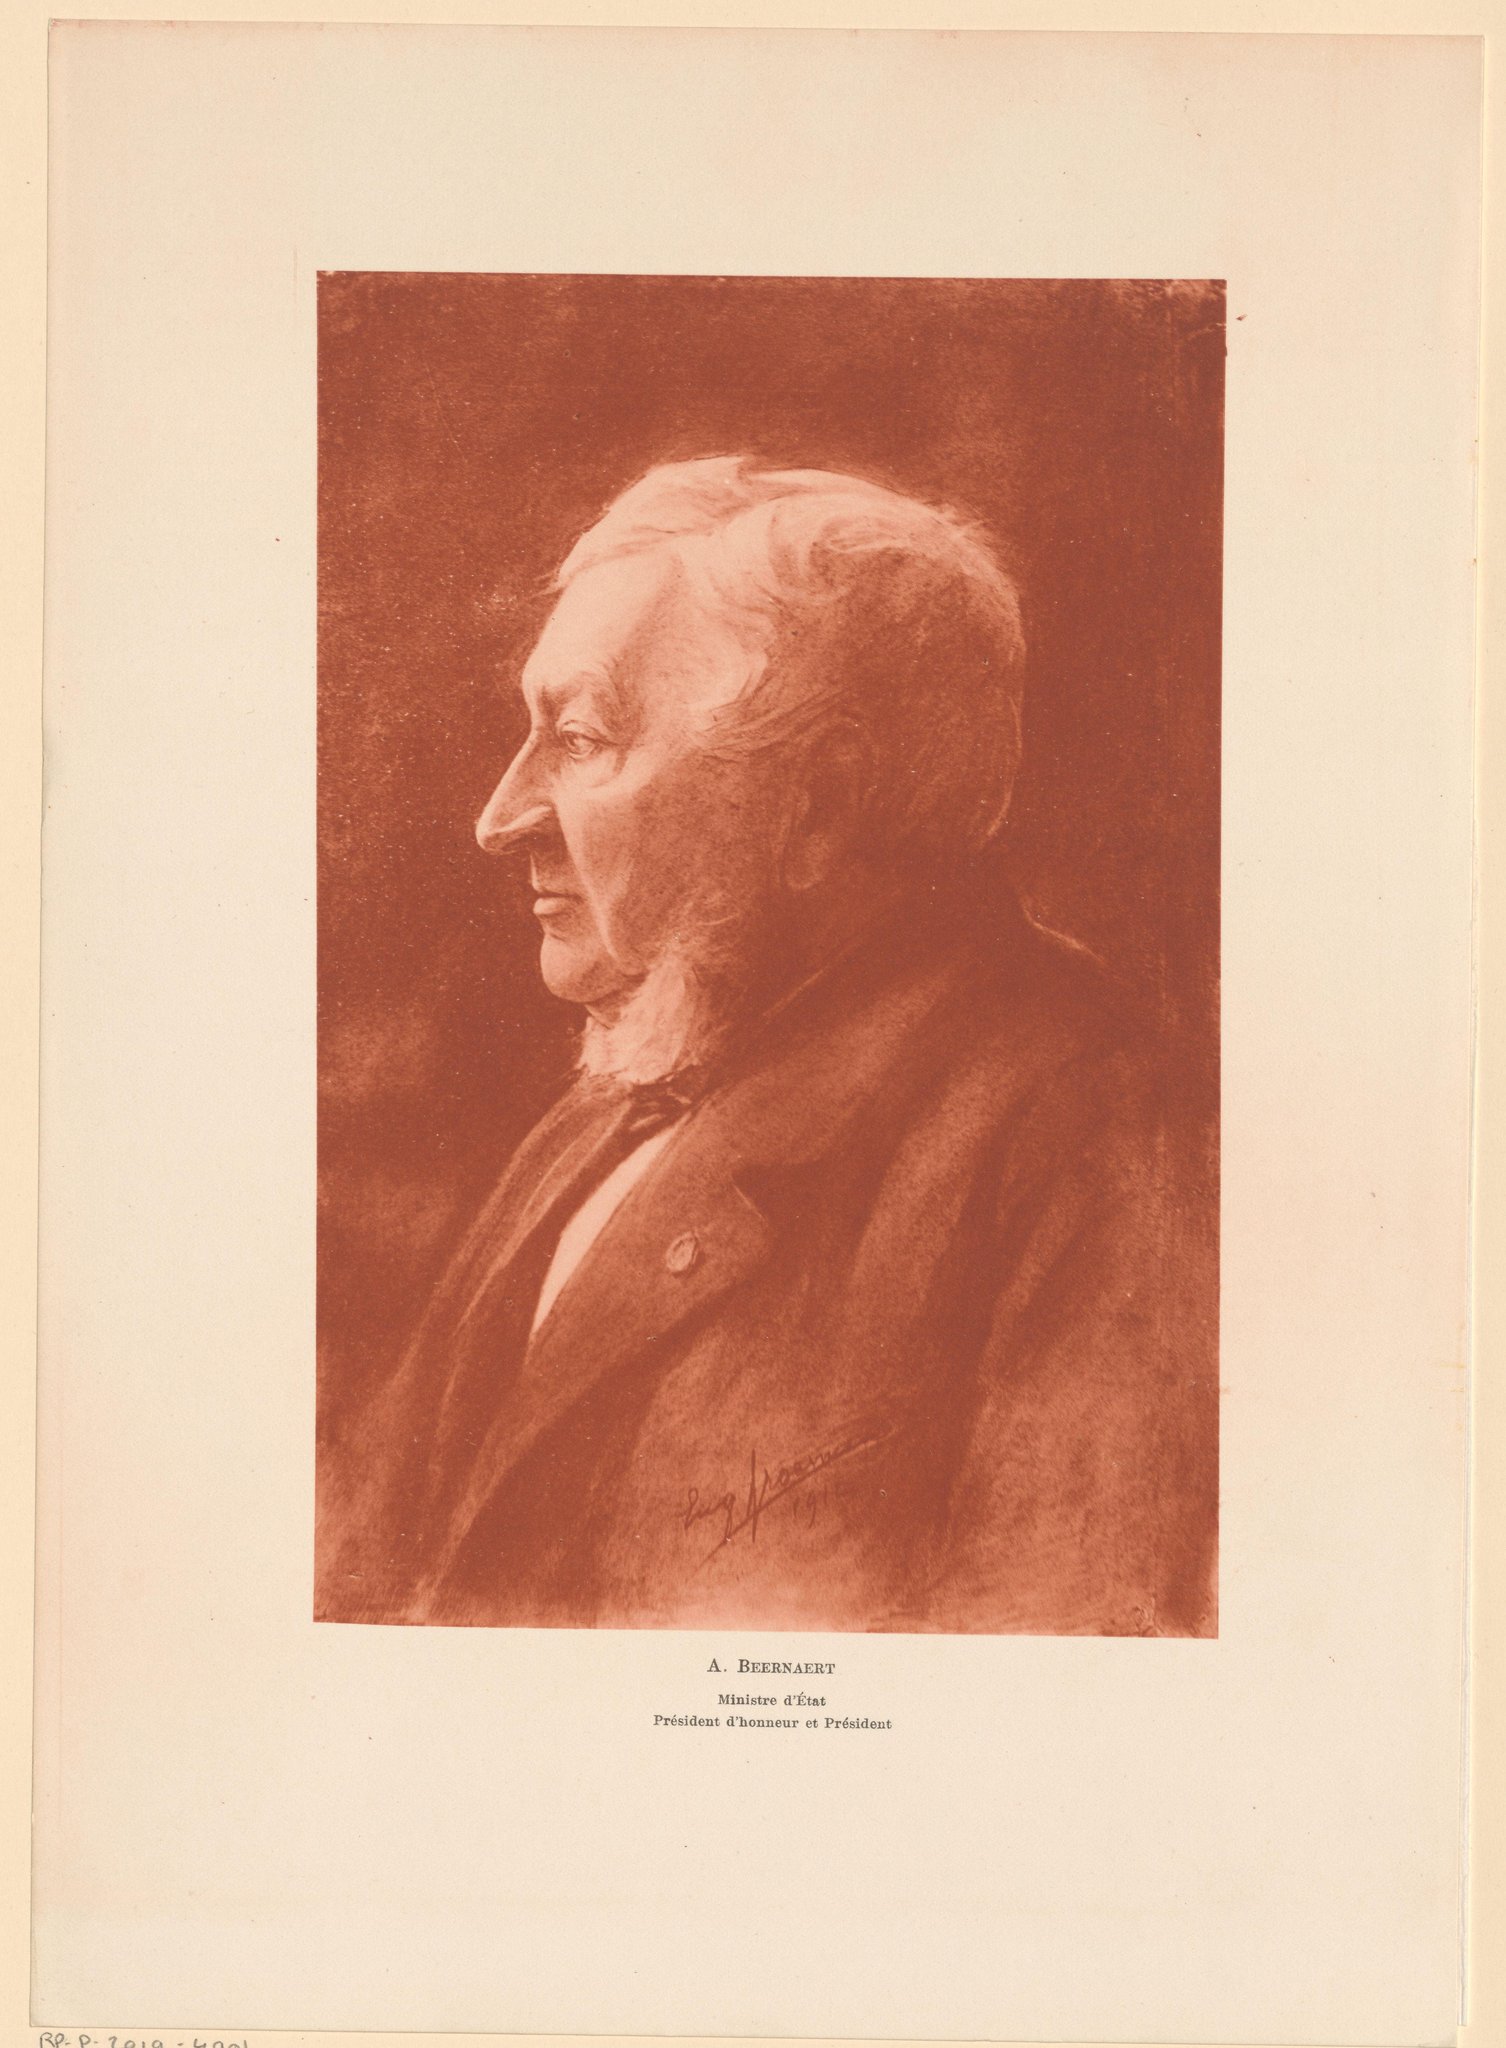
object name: photomechanical print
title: Portret van August Beernaert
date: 1910-1930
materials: paper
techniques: photograph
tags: politician, historical persons